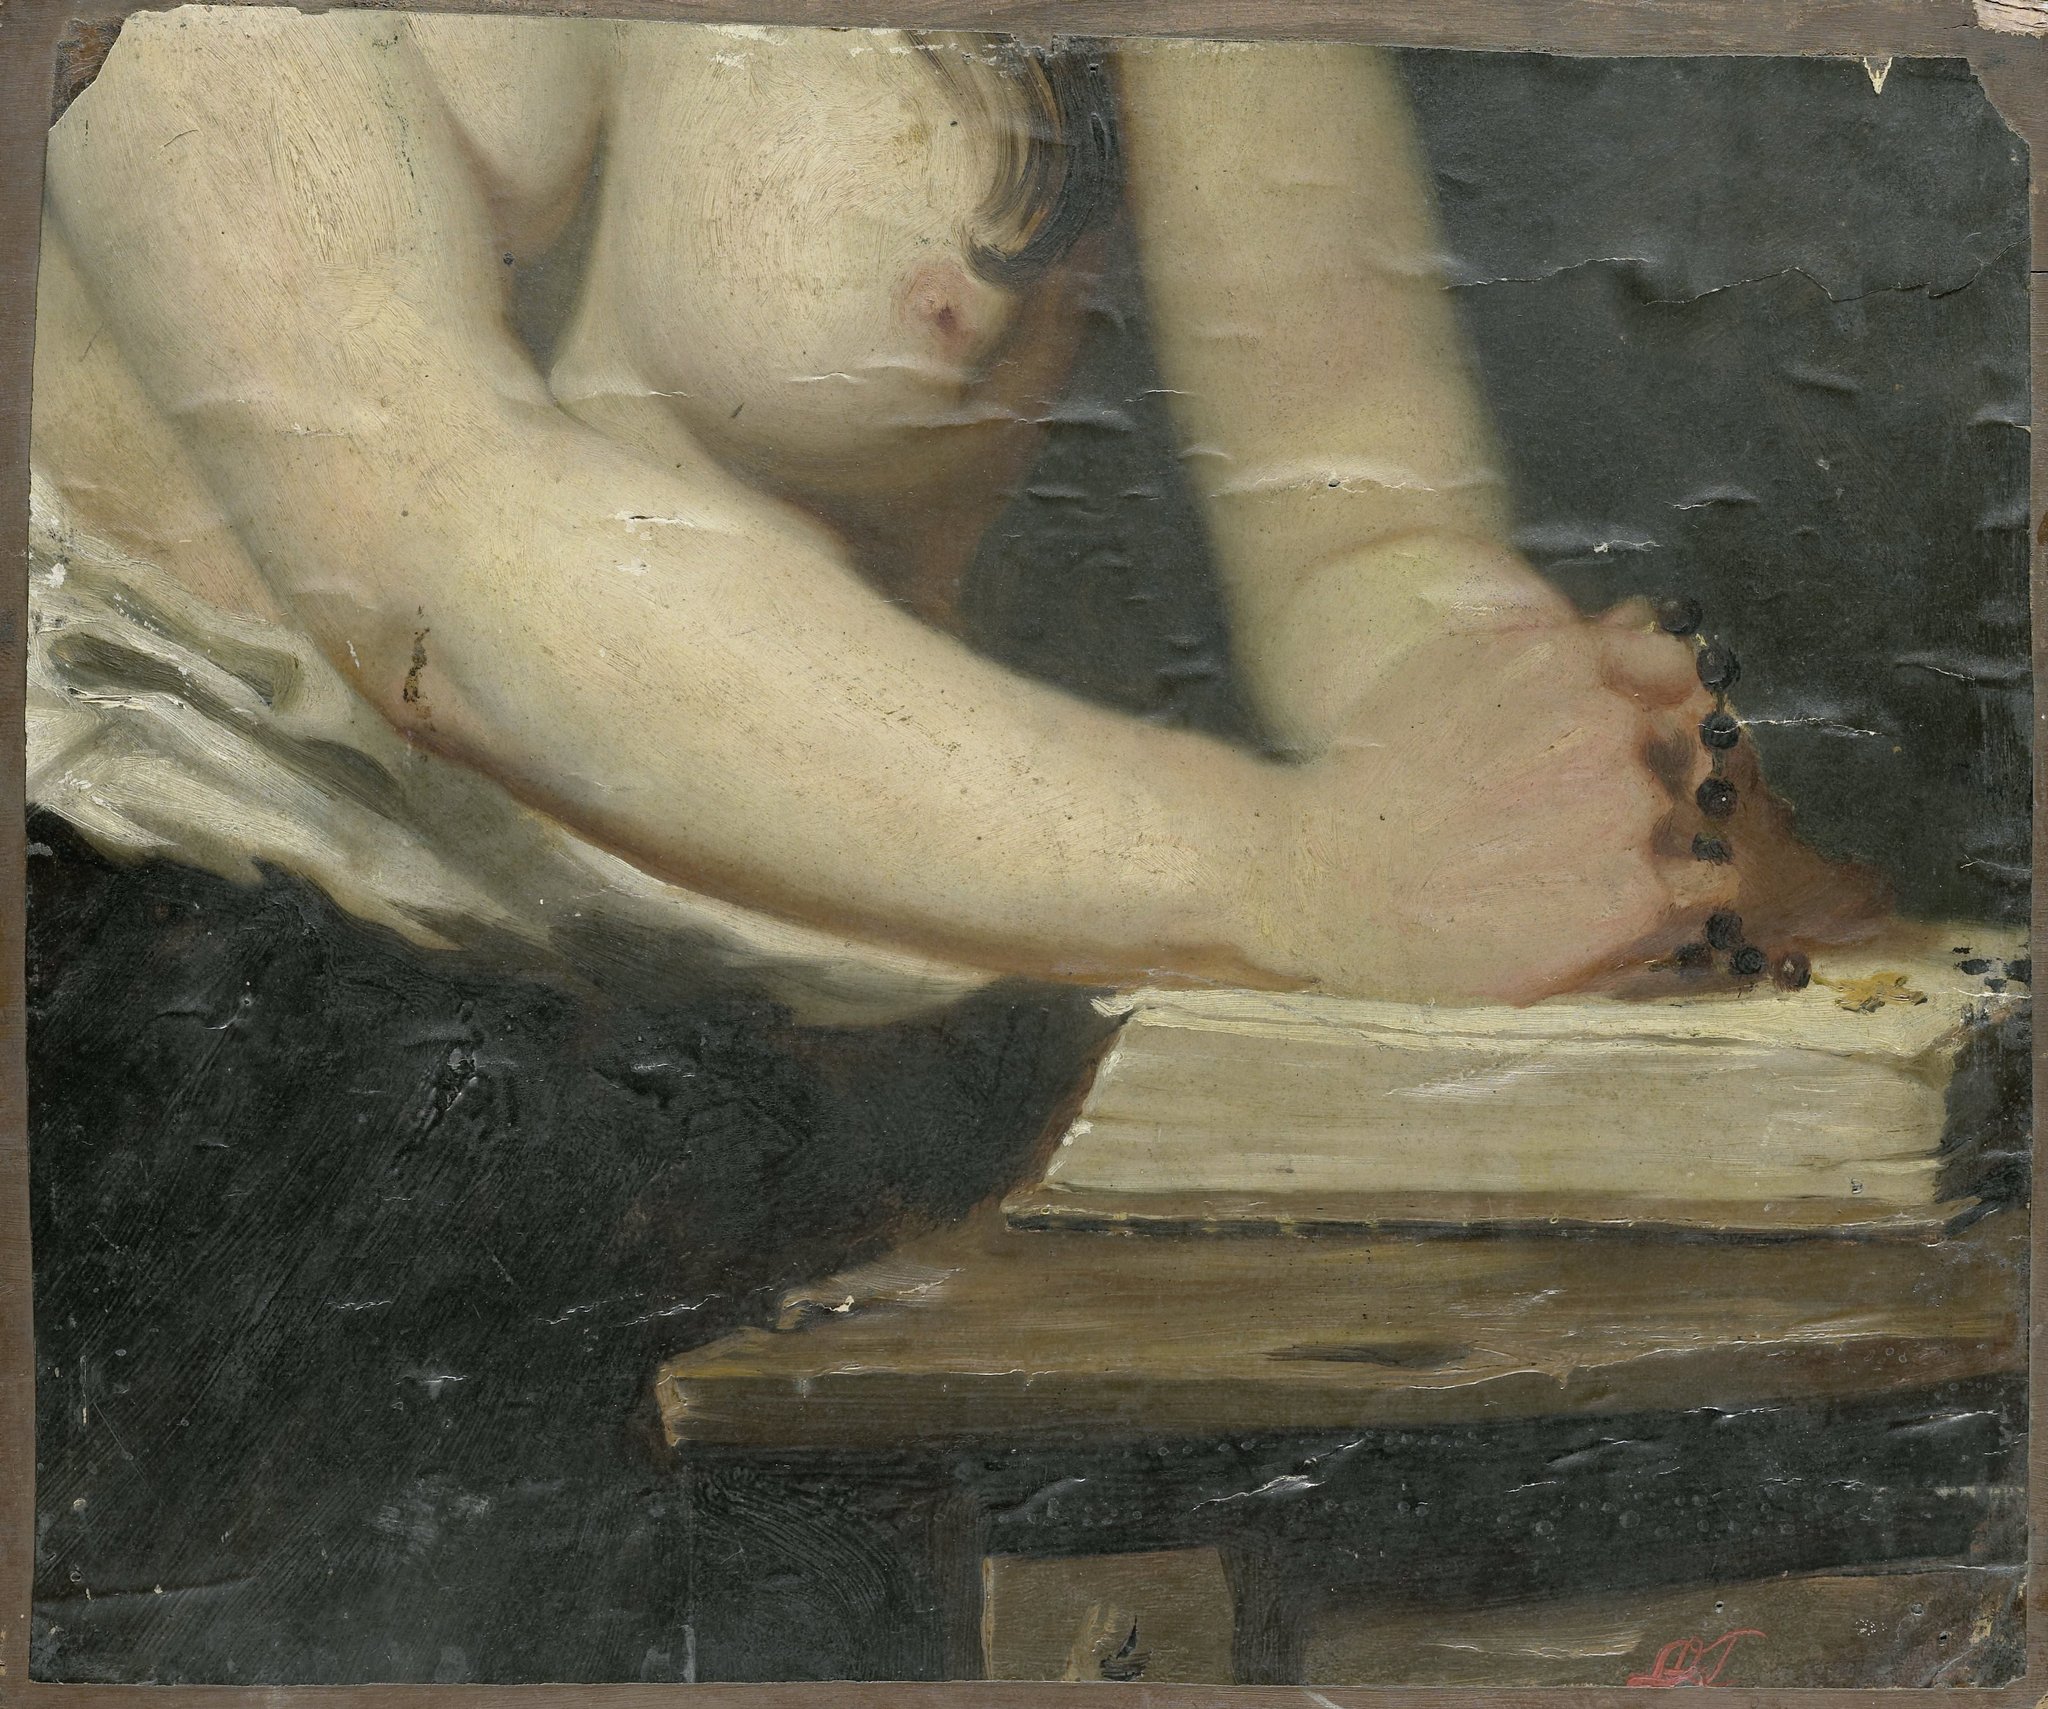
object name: fragment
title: Mary Magdalene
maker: lourens alma tadema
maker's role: draughtsman, print maker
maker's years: 1836-1912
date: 1846-1854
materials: oil, paint, panel, paper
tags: the penitent st. mary magdalene (often before a cave, possibly at la sainte-baume hill): her long hair covers her (naked) body, she reads, meditates or raises her tear-filled eyes towards heaven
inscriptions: inscription: ‘Alma Tadema. 't Kopje hiervan hangt in 't Rijksmuseum’, signature: ‘L.A.T.’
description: Borst en armen van een jonge vrouw. De handen gevouwen op een opengeslagen boek. Vormt samen met SK-A-2289 een borstbeeld van Maria Magdalena.